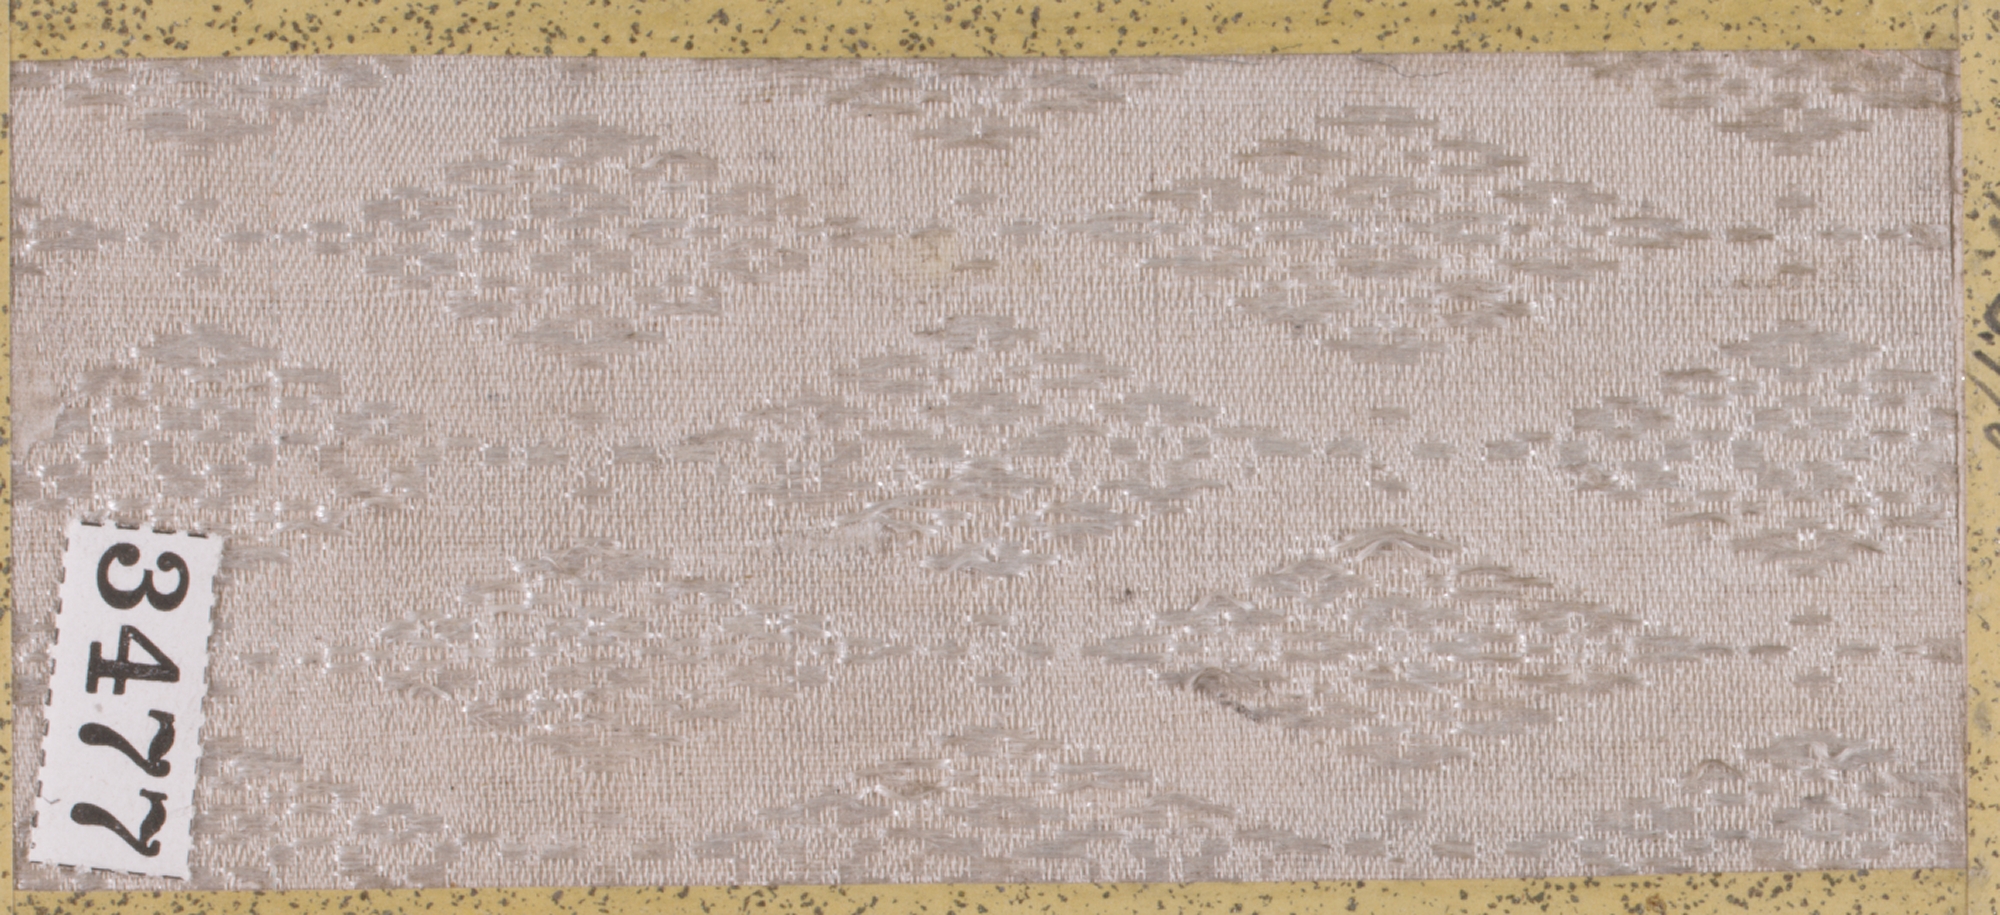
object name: sample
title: Textile Sample from Sample Book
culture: japanese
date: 1801-1900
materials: silk